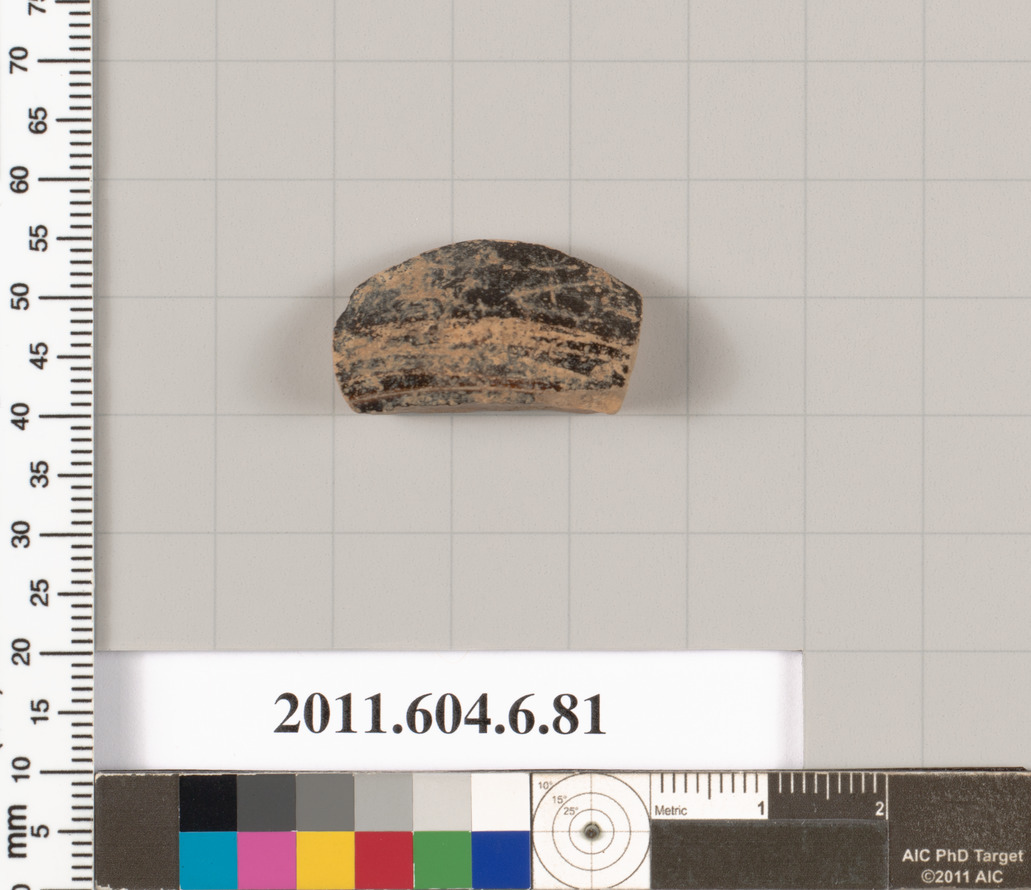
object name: undetermined open shape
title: Terracotta fragment of an open shape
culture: greek, attic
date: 600-401 BCE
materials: terracotta